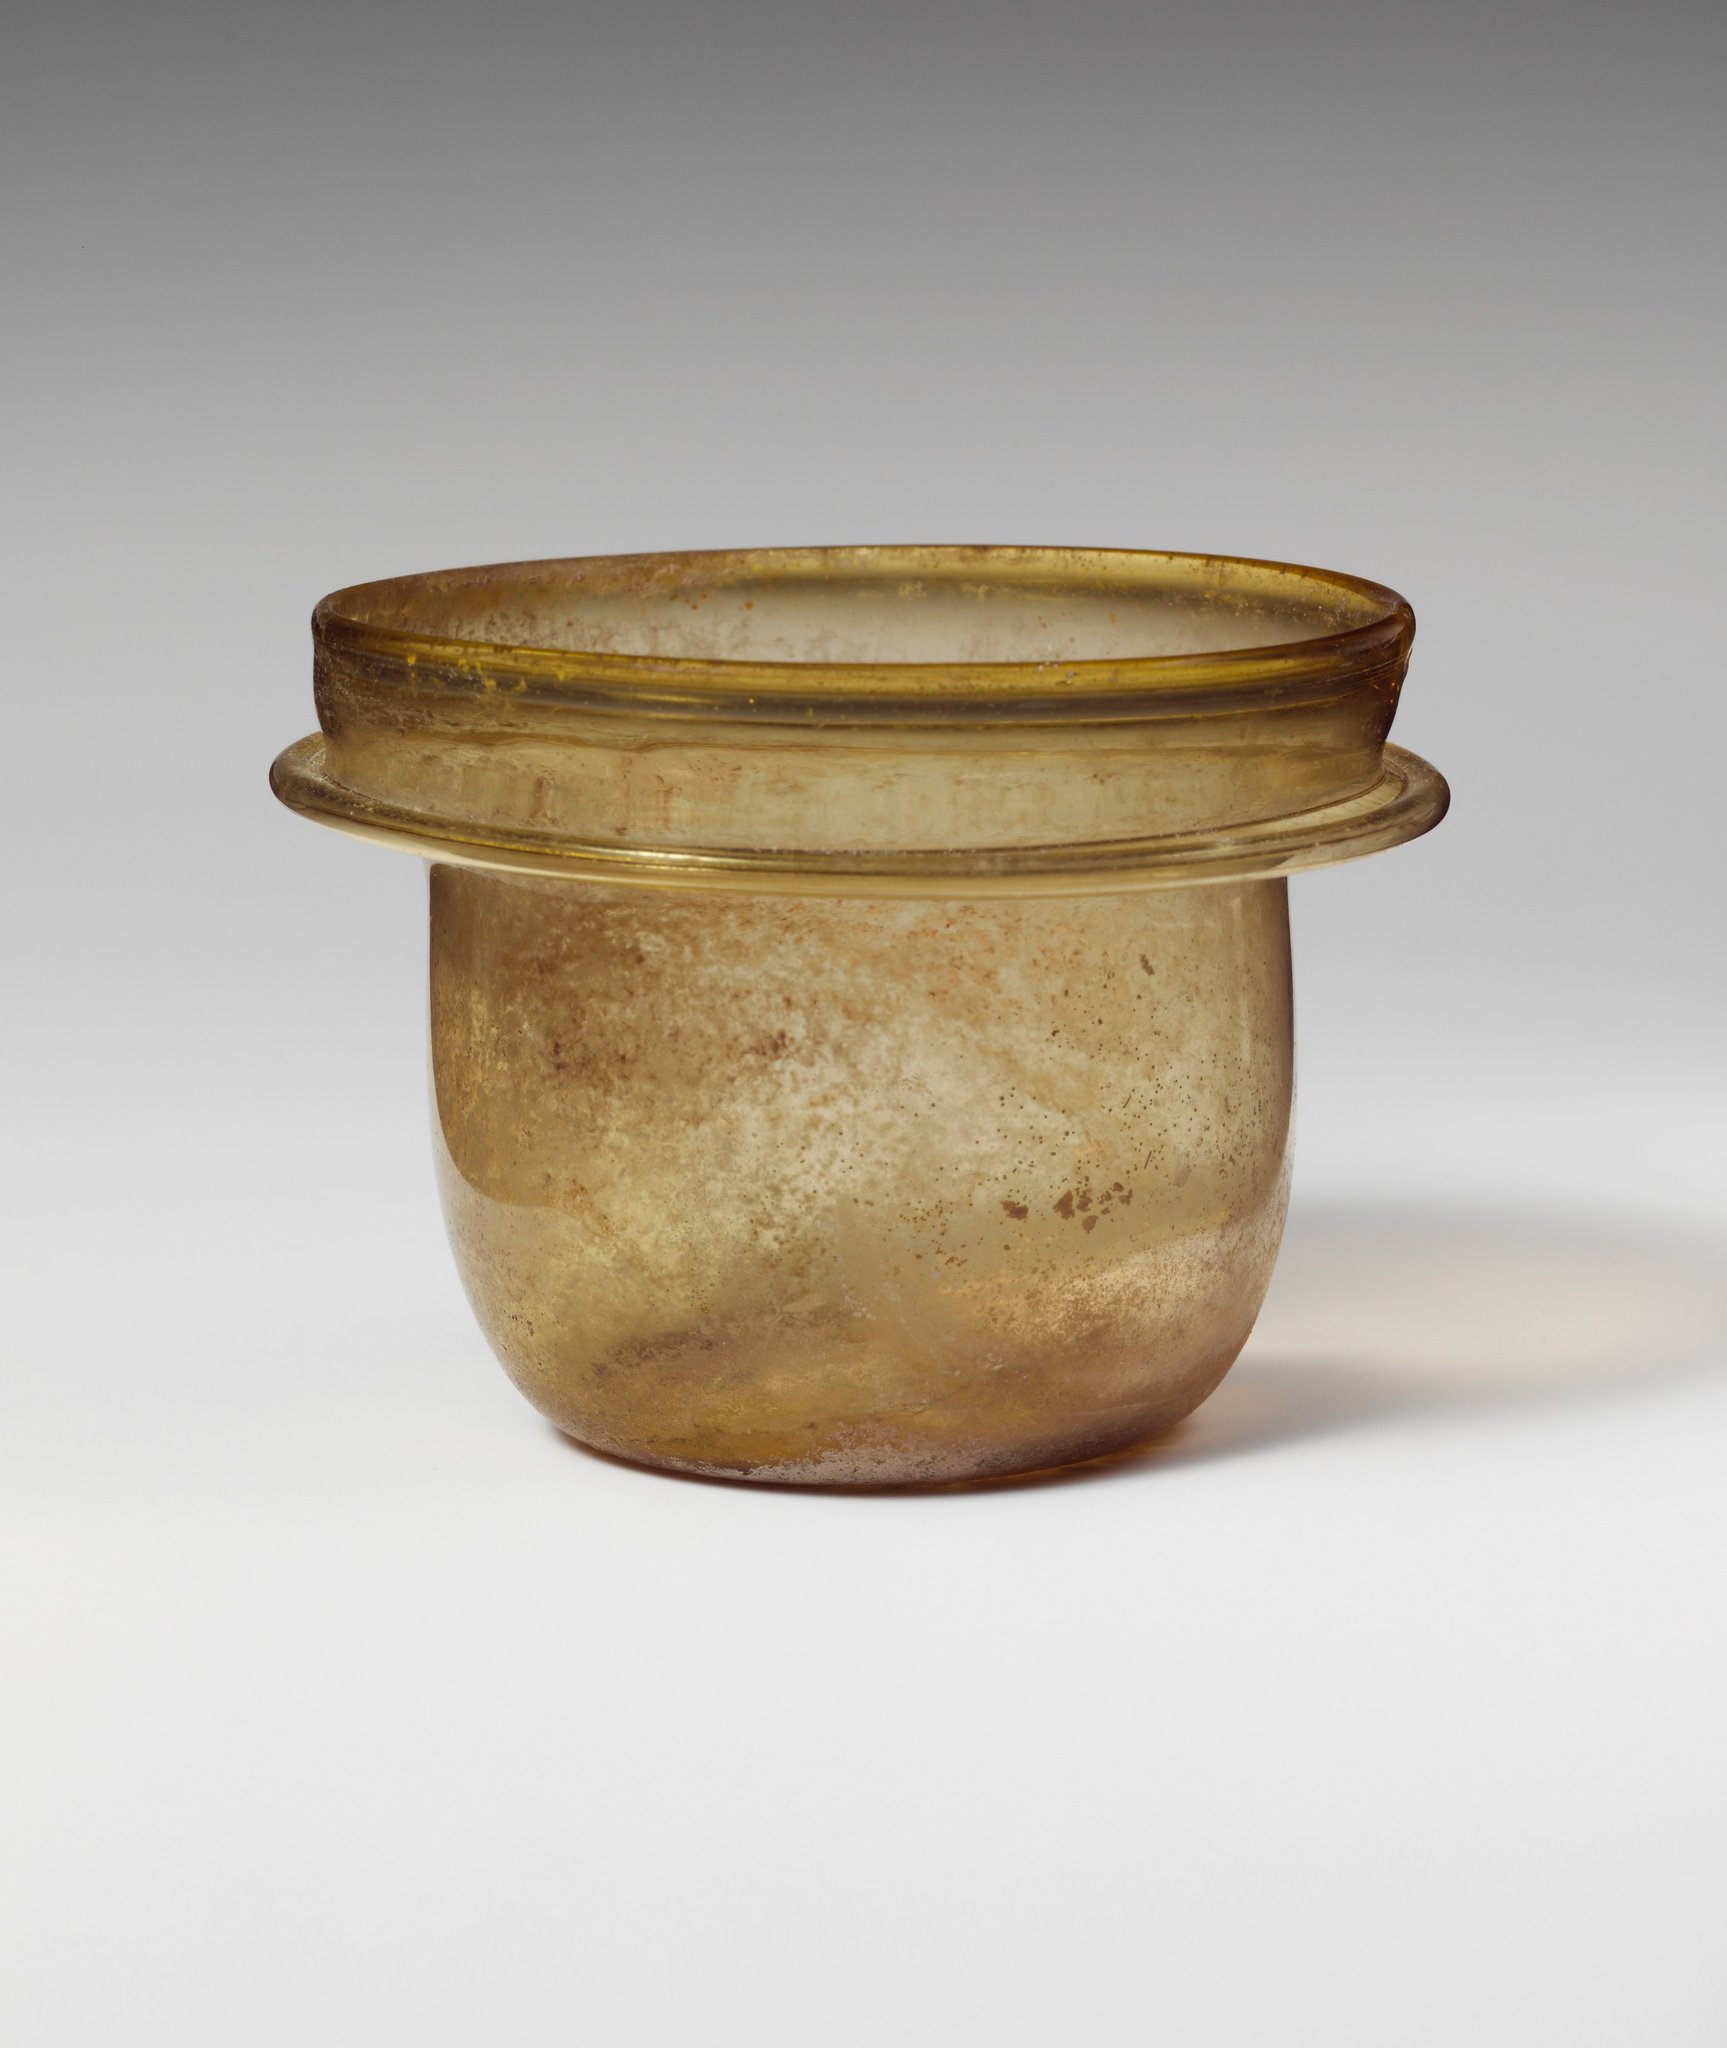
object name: cup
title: Glass cup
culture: roman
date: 34-200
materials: glass